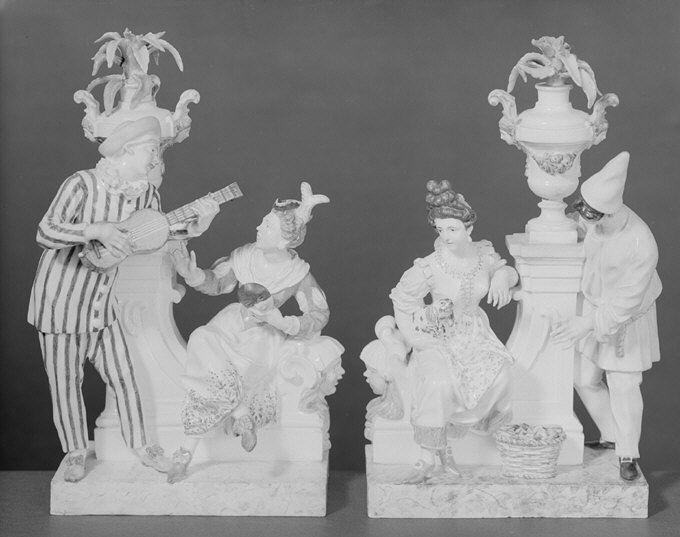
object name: group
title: Pair of Italian comedy actors (Pulcinella and Elizabeth (?))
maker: real fabrica de buen retiro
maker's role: factory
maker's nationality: spanish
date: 1770-1780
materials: soft paste porcelain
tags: musical instruments,men,women,music,actors